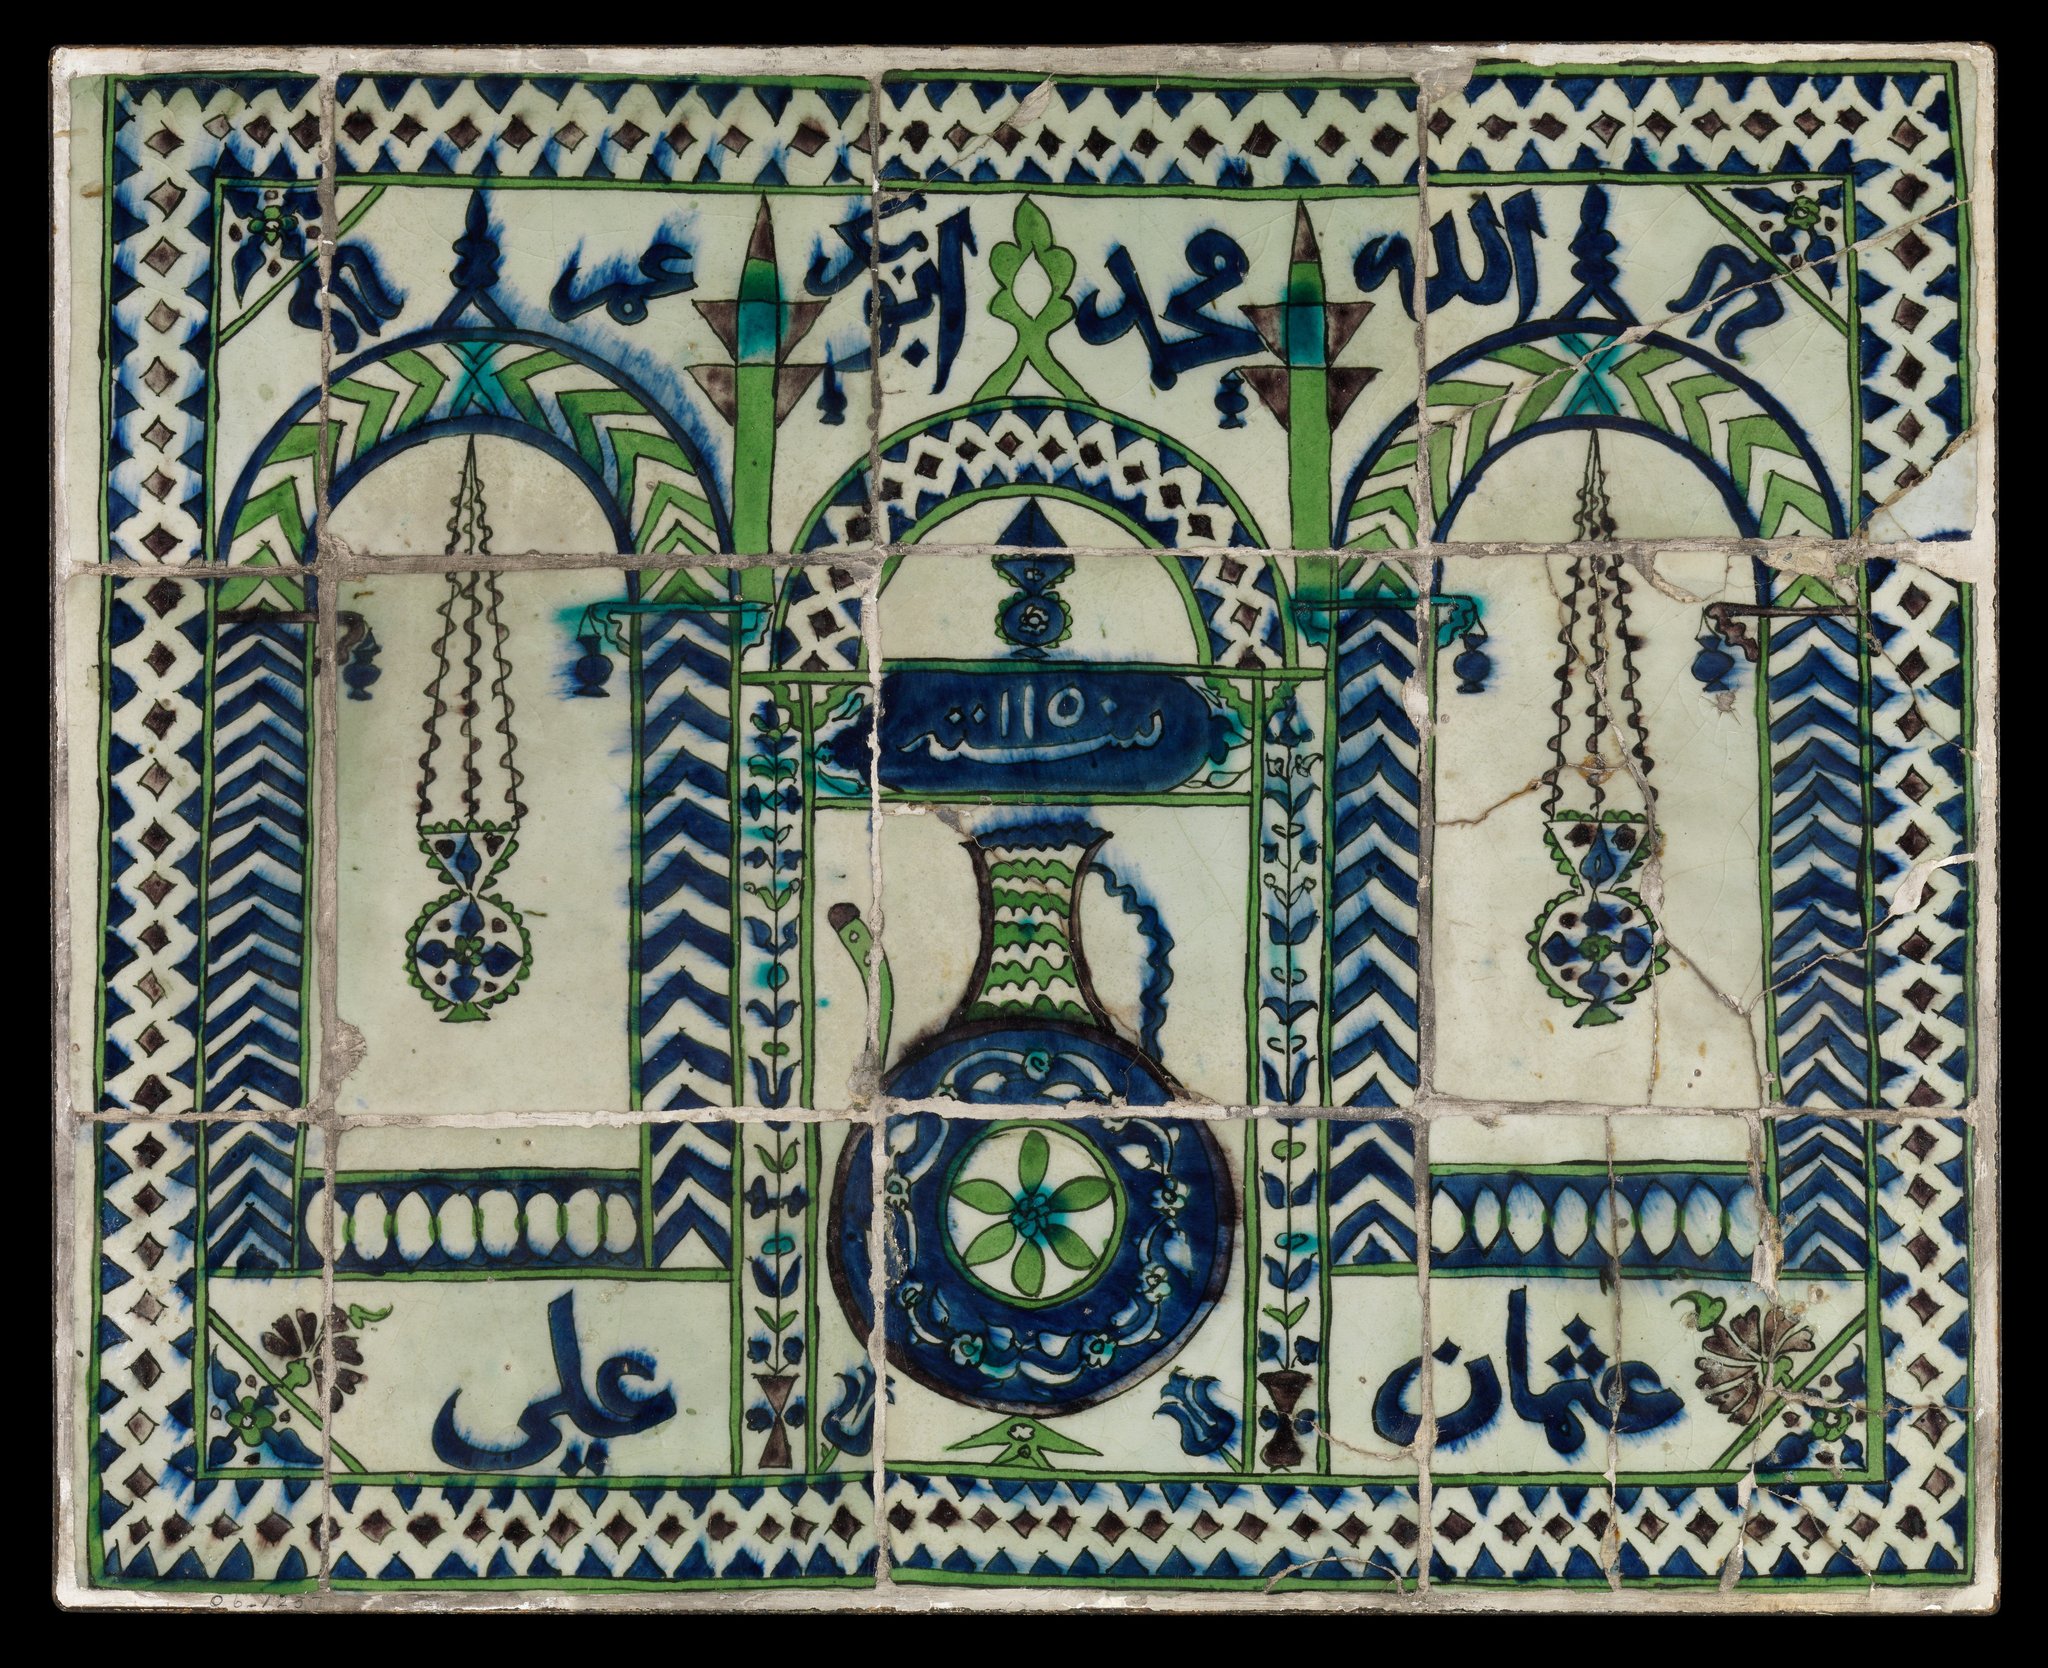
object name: tile panel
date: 1701-1800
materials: stonepaste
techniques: glazing, painting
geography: syria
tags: ewers,lamps